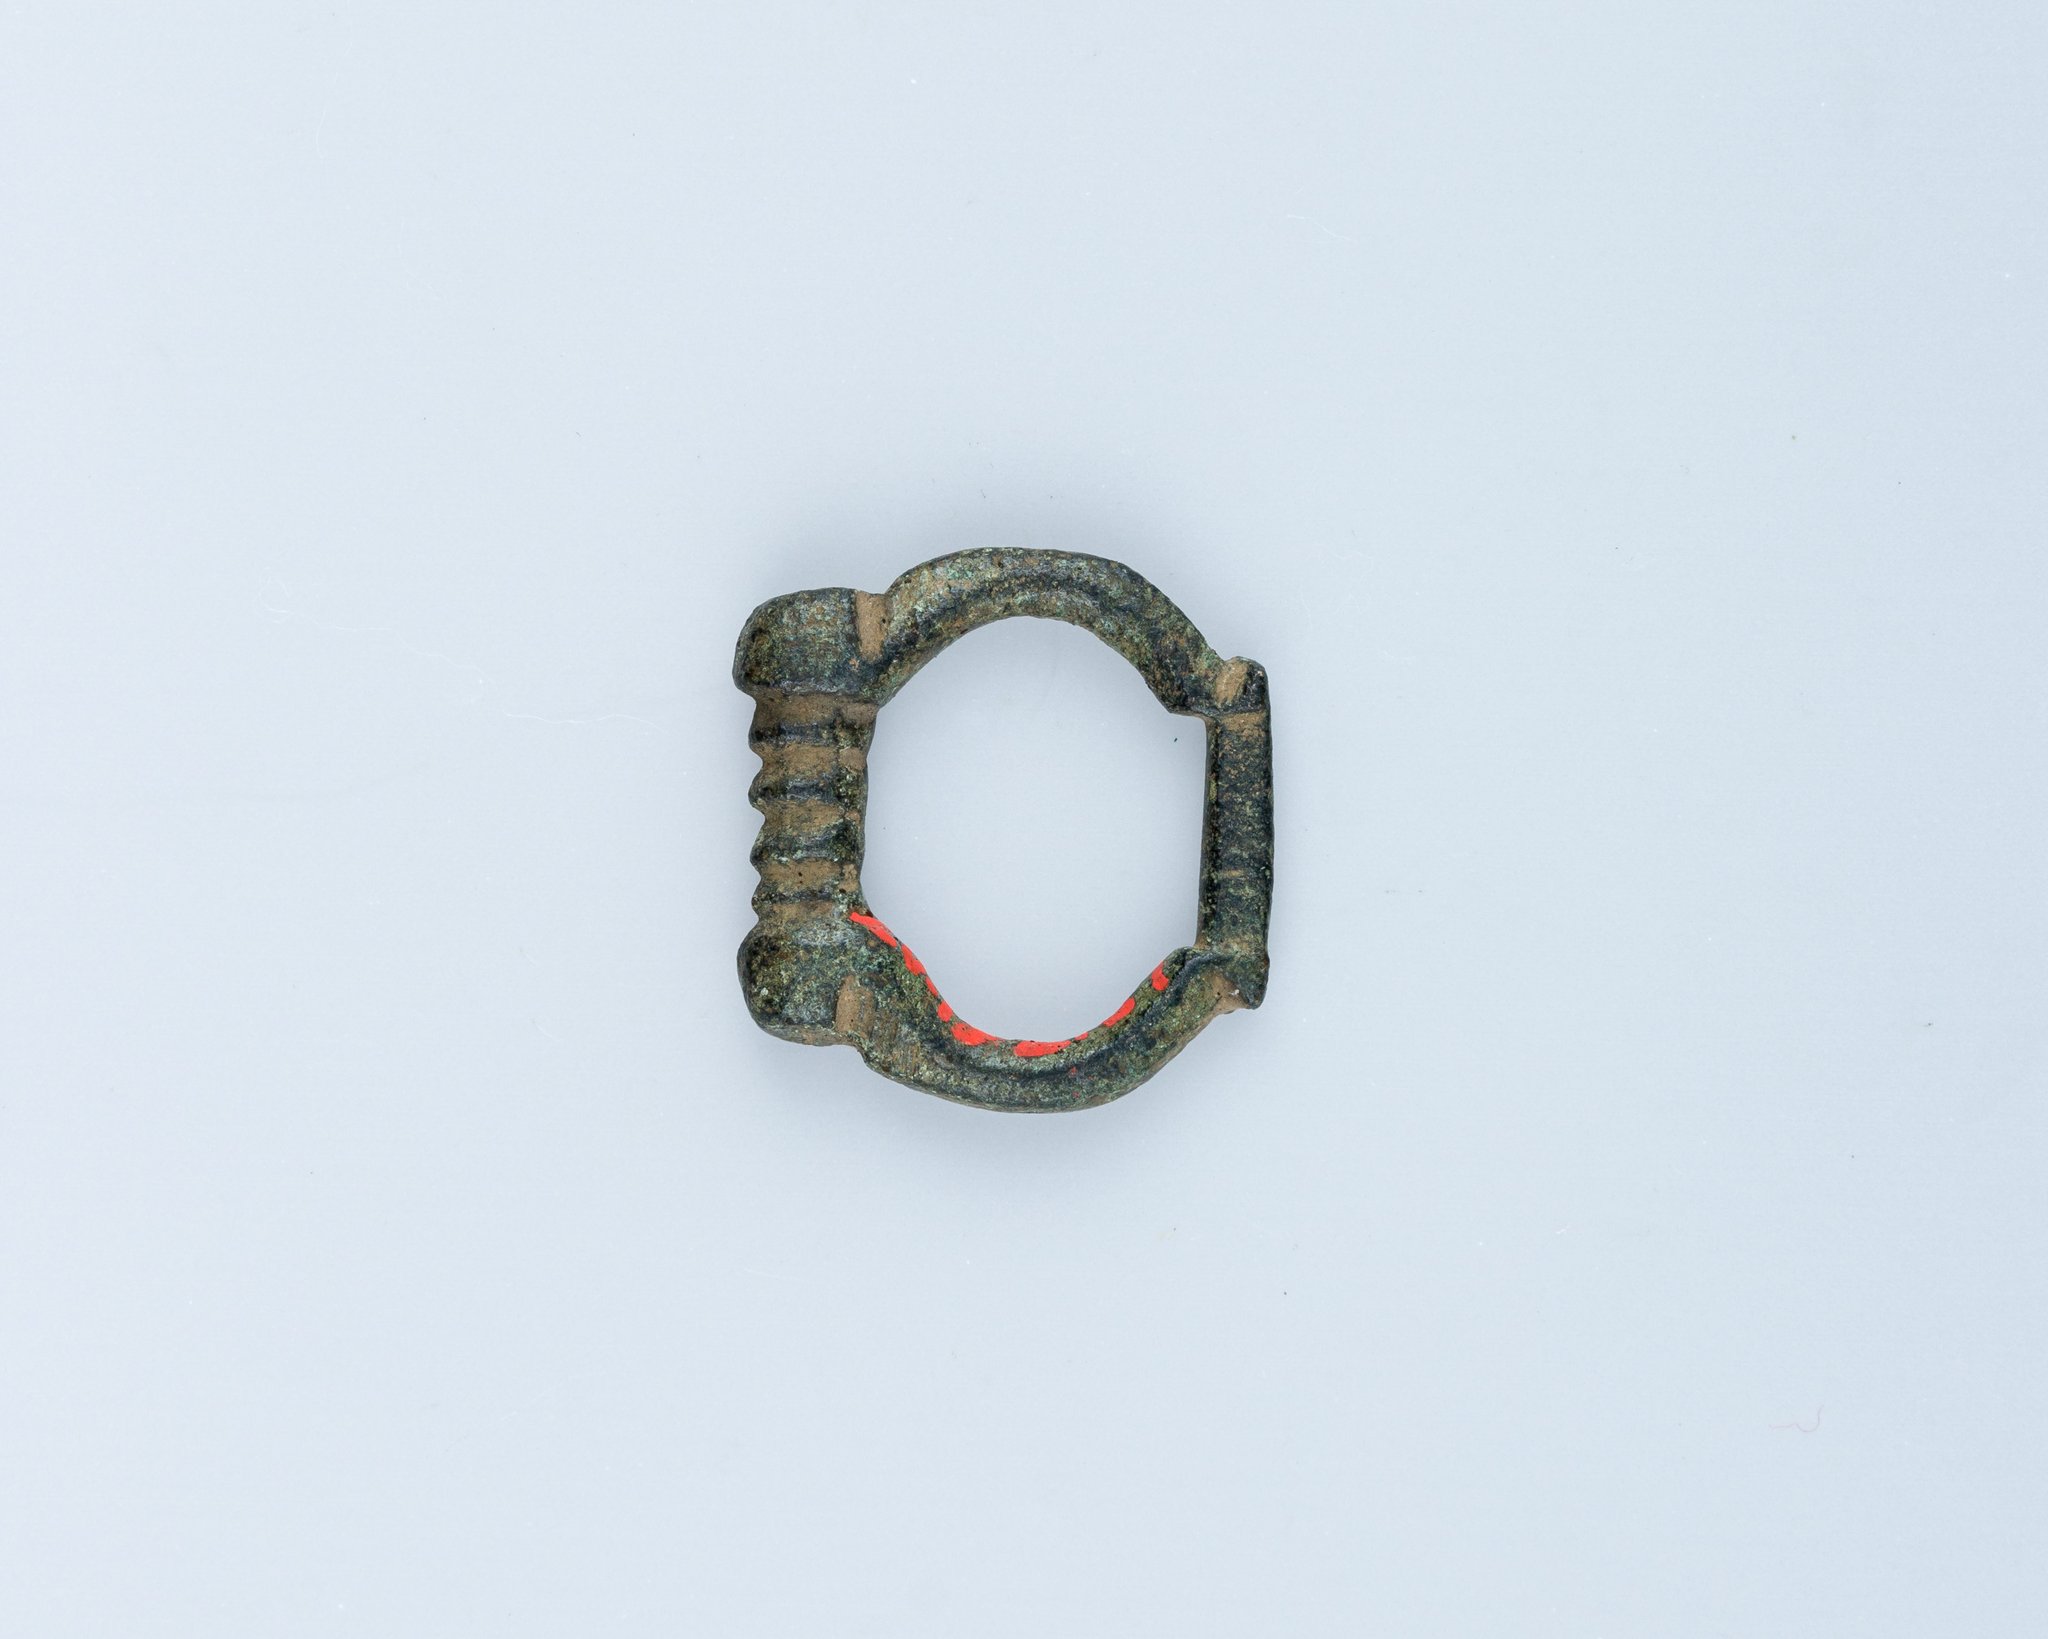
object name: buckle loop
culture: french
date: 1301-1400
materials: bronze, patina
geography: france